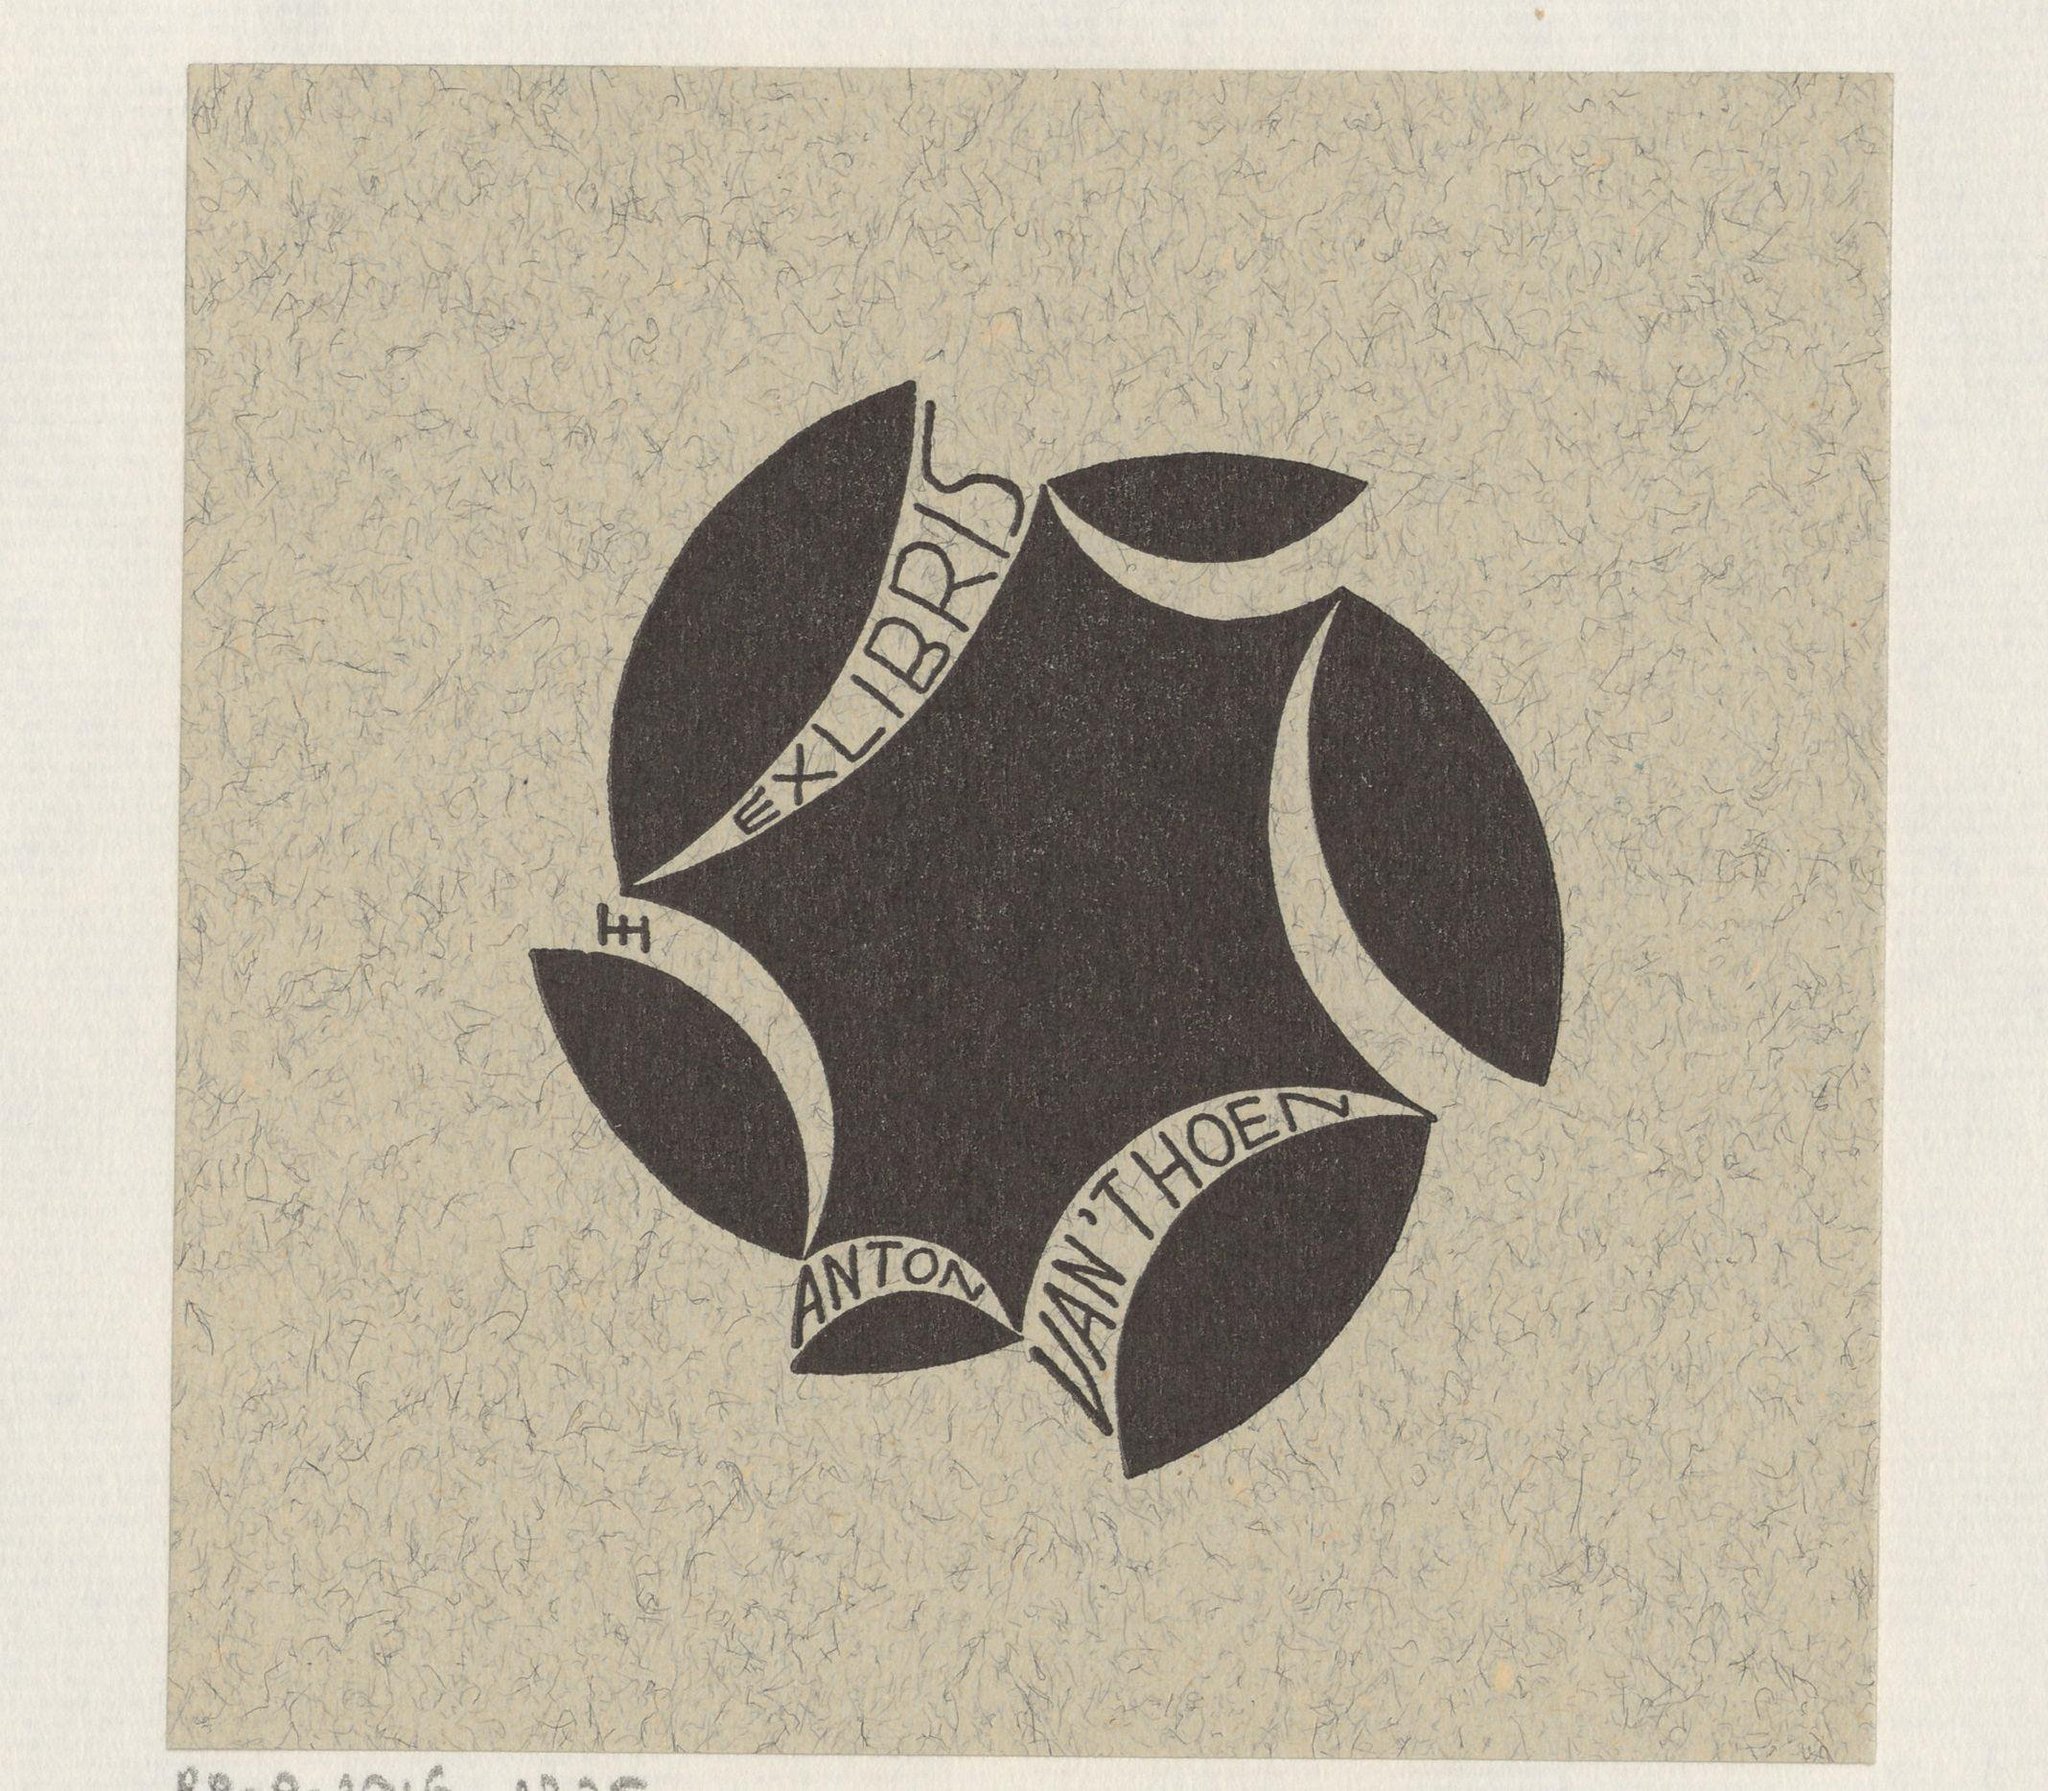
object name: bookplate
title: Ex libris van Anton van 't Hoen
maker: hans van t hoen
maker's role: print maker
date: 1965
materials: paper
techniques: printing block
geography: netherlands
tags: flowers ~ ornament - aa - stylized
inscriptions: workshop stamp: ‘P1 - cliché / Hans van 't Hoek / 1963’